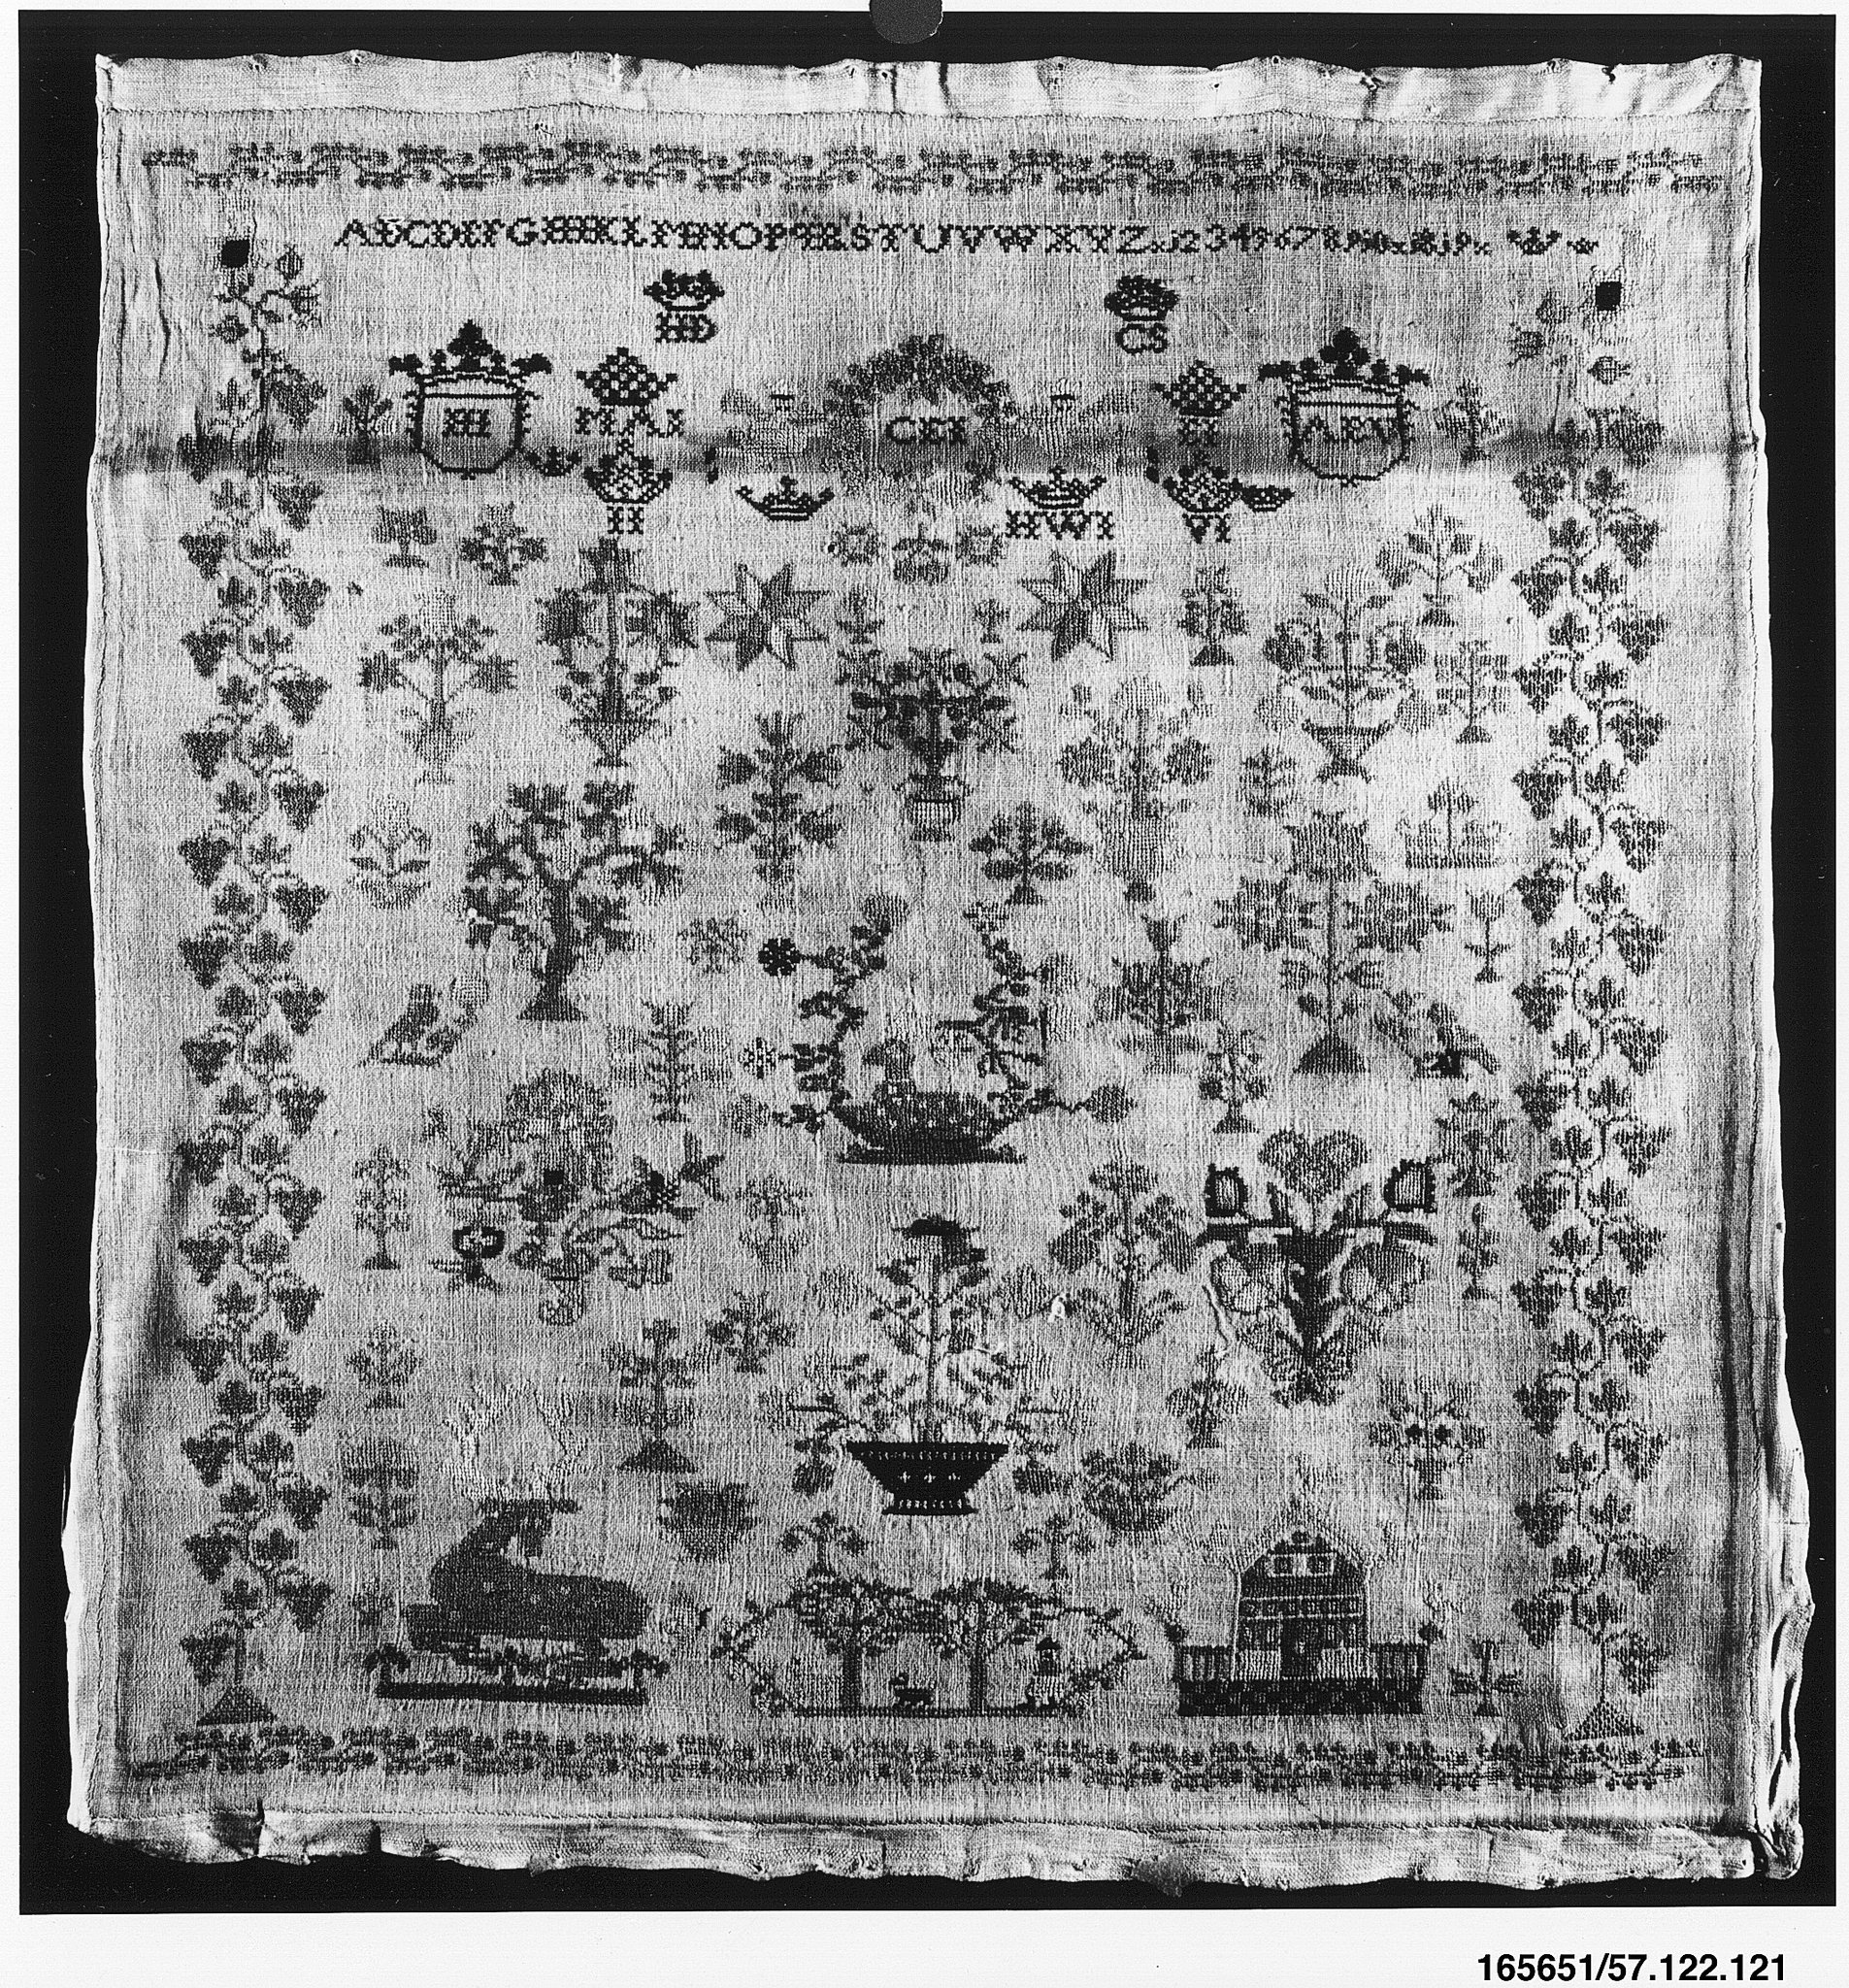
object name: sampler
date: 1819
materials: cotton, silk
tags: animals,flowers,insignia